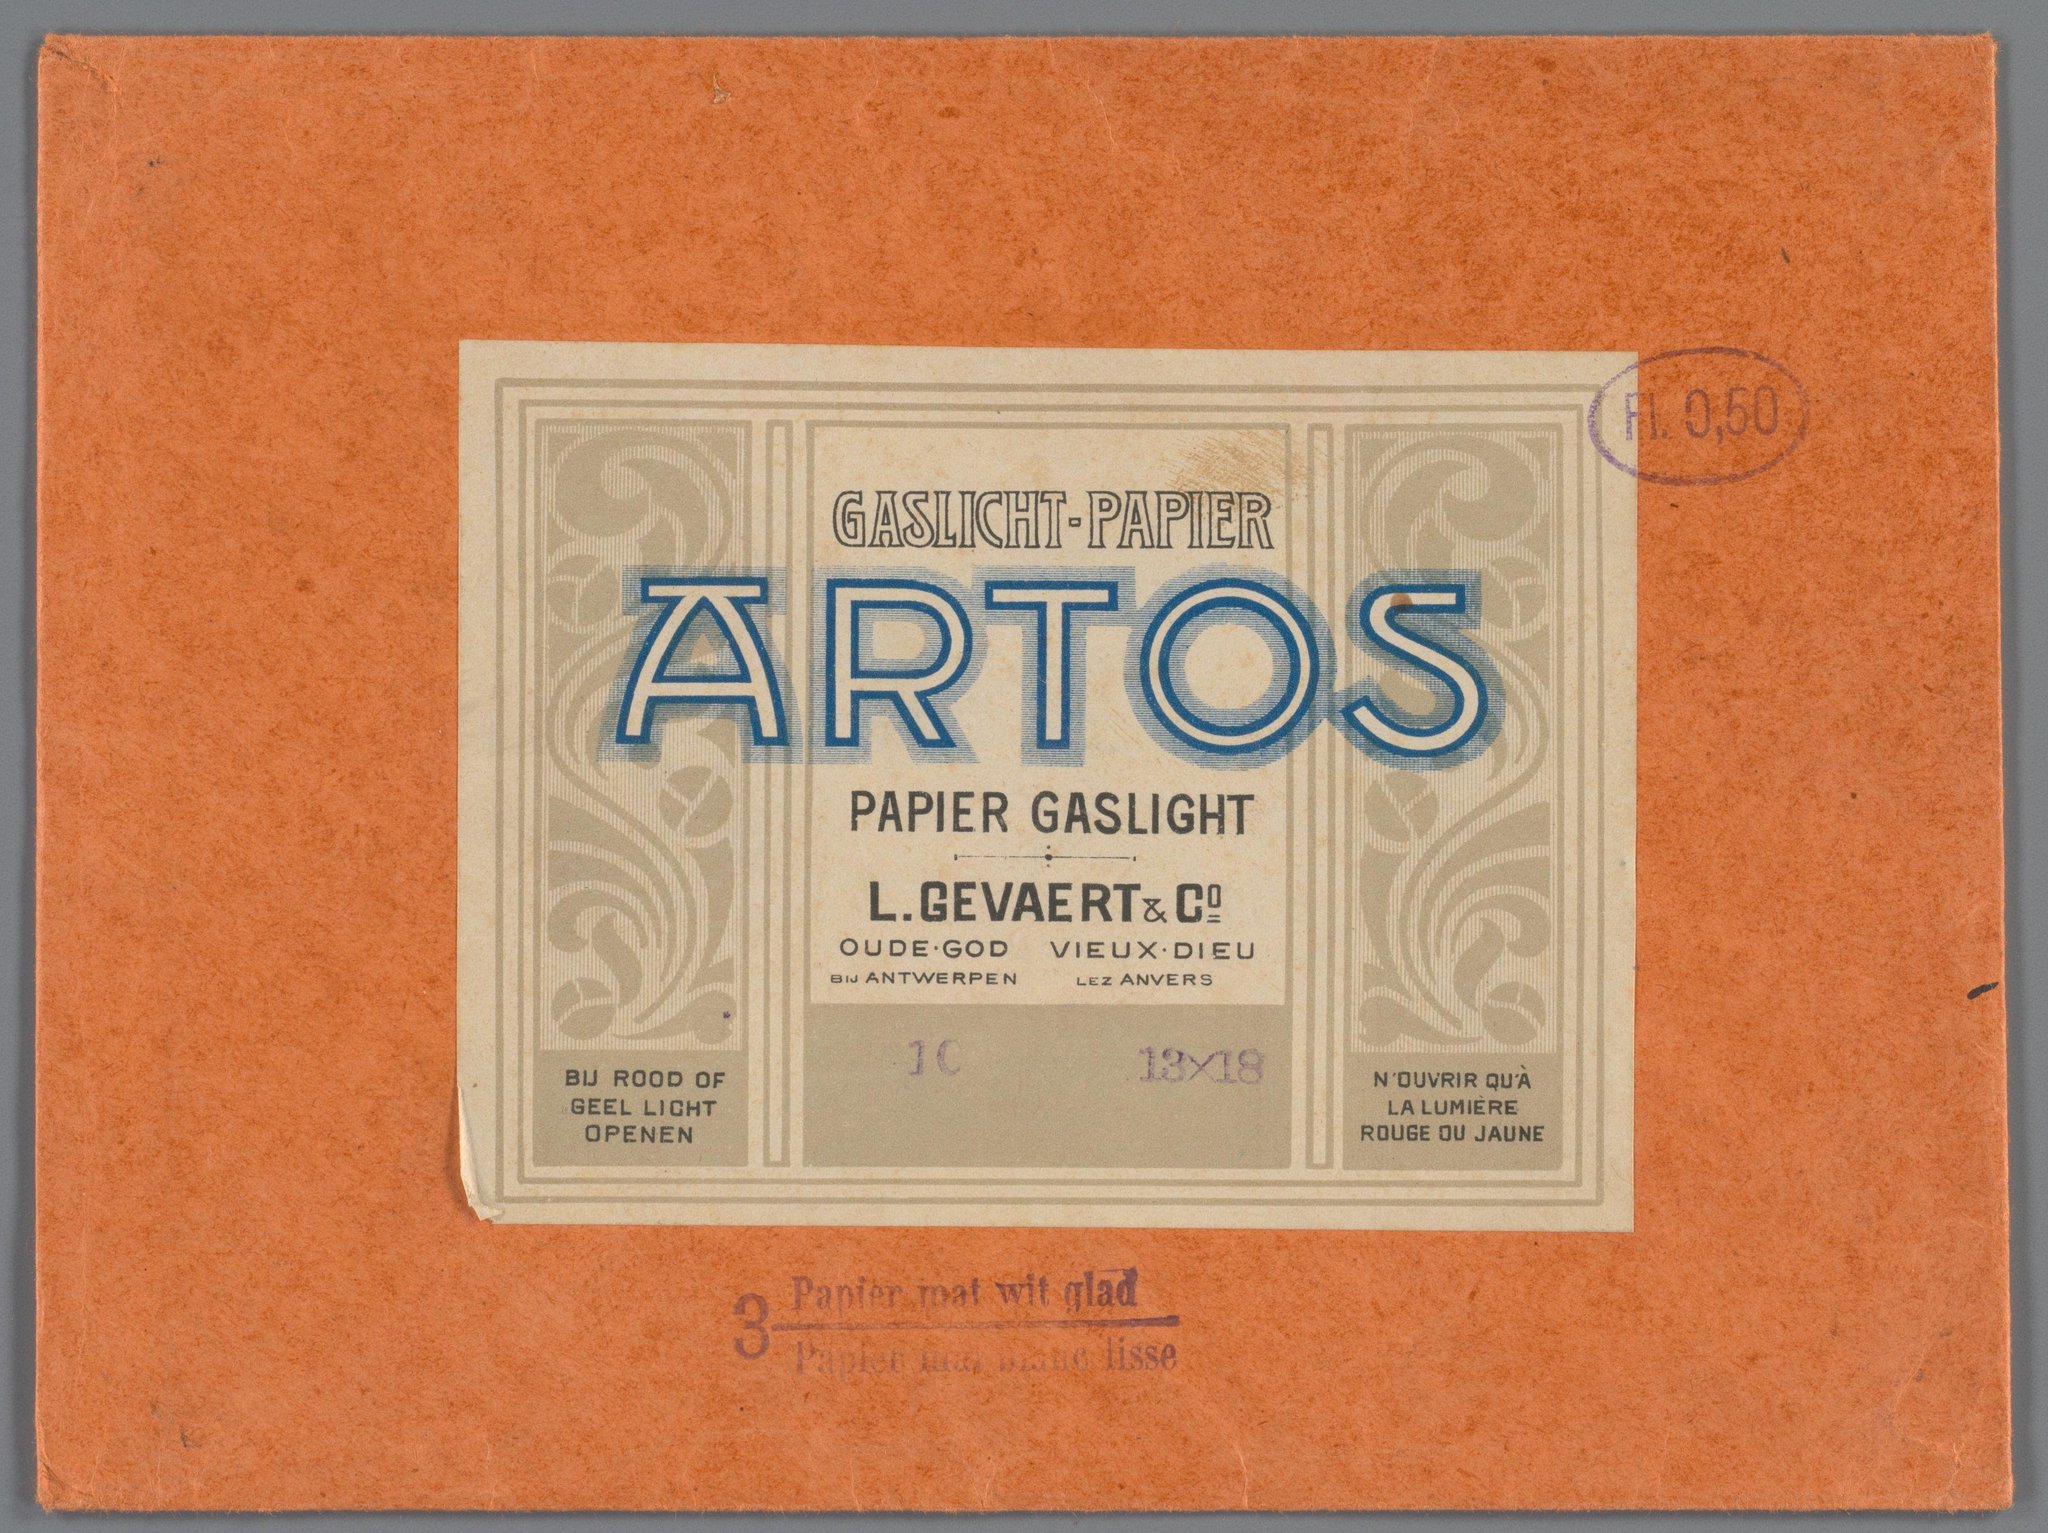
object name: envelope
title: Gaslicht-papier Artos L. Gevaert & Co.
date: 1911-1920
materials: paper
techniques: letterpress printing, lithograph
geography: antwerp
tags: processing film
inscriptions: stamp: ‘3 Papier mat wit glad/ Papier mat blanc lisse’, stamp: ‘A.W.P./ 49943/ DRPP’